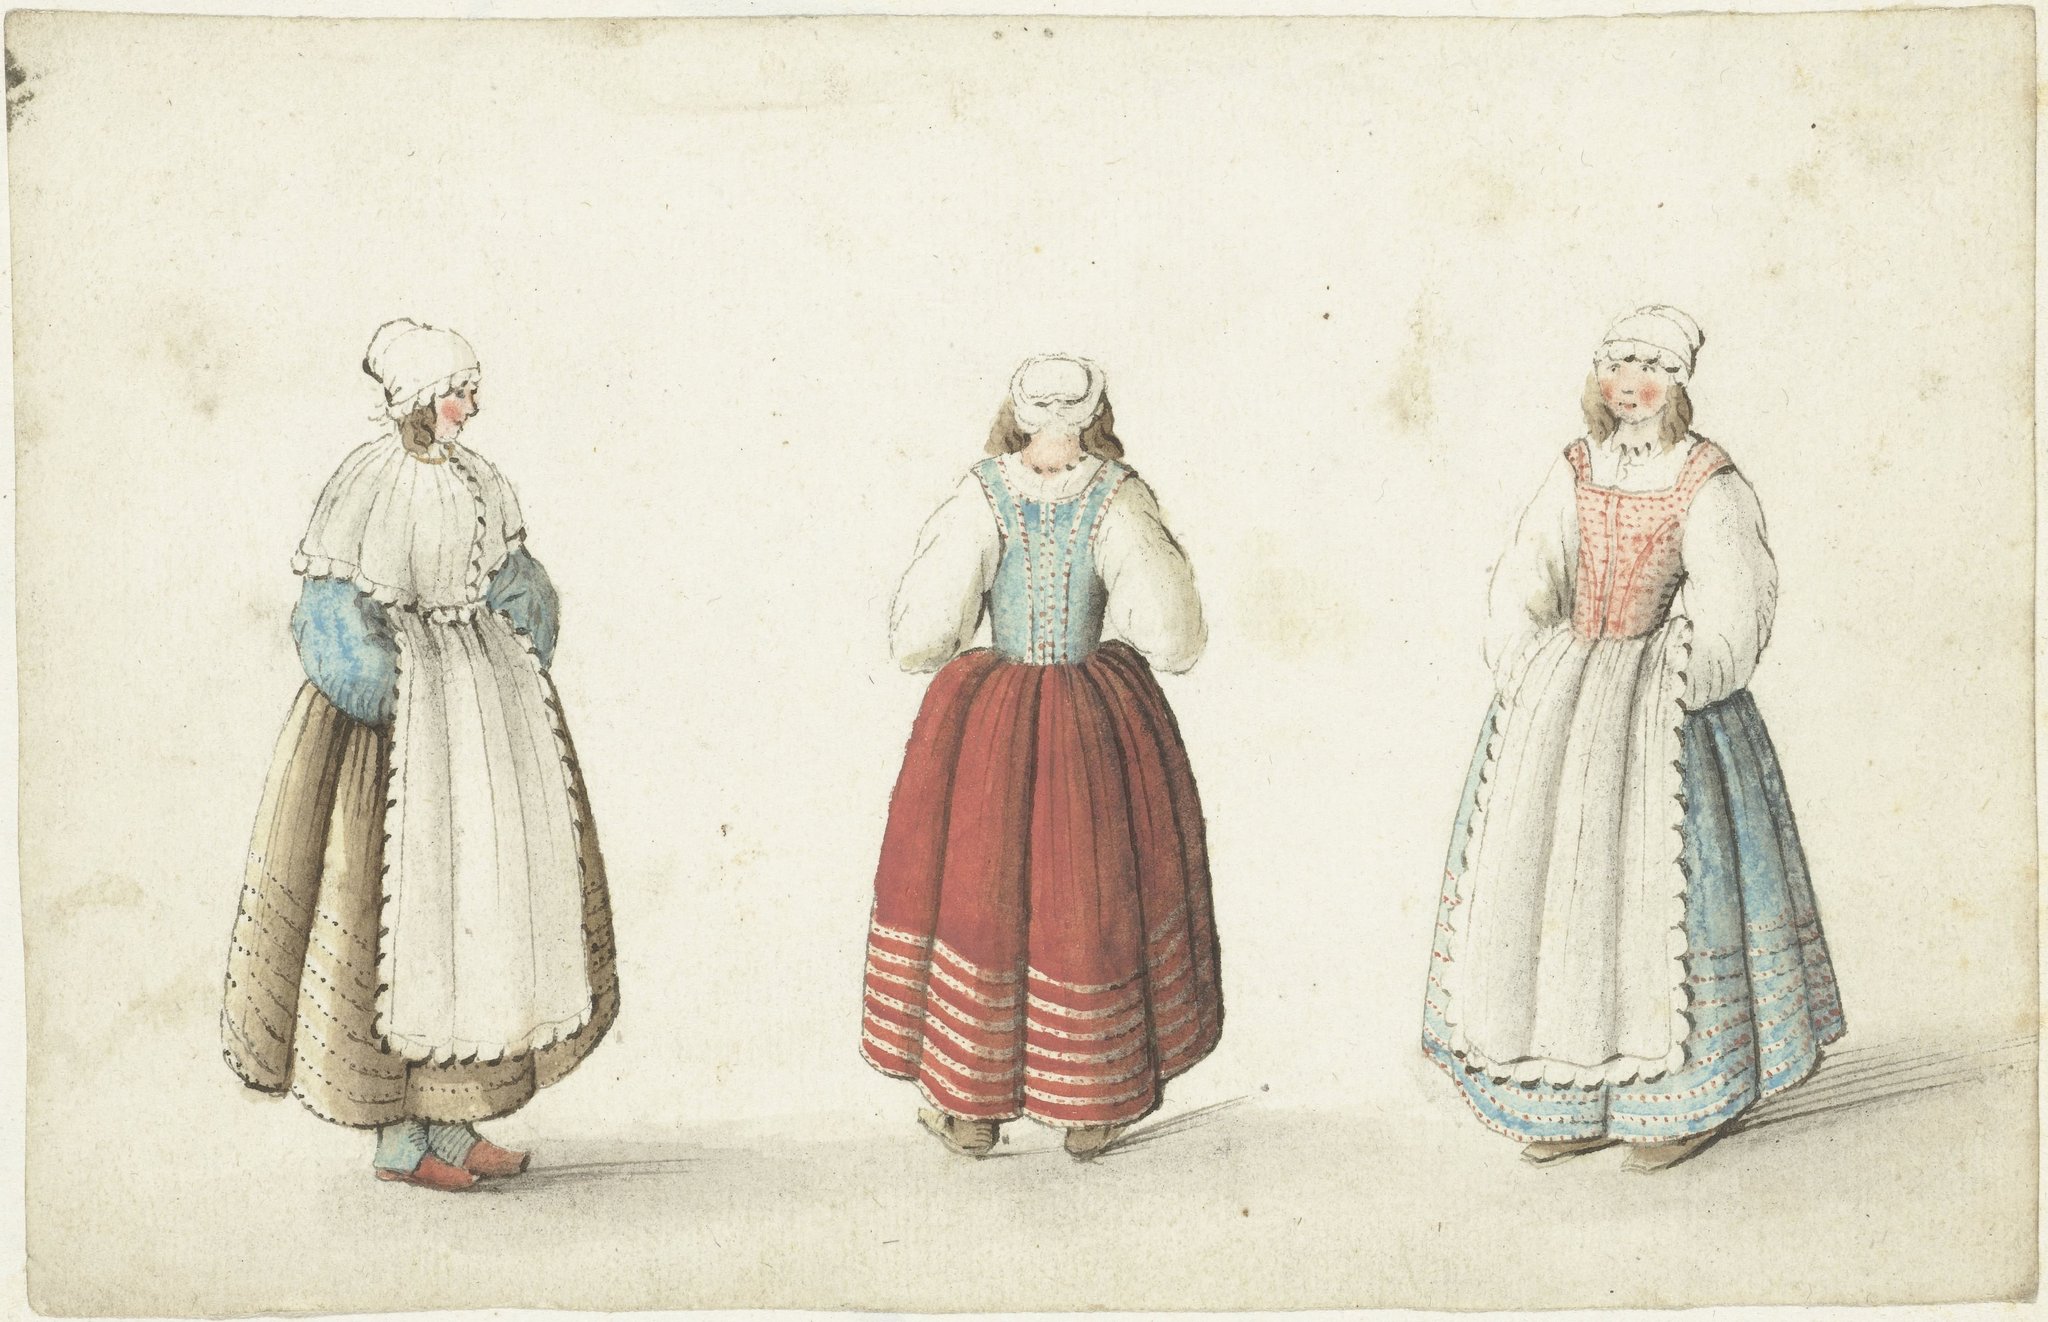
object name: drawing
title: Drie staande vrouwen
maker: gesina ter borch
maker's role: draughtsman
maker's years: 1633-1690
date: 1646-1654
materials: ink, paper, watercolor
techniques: brush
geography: zwolle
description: Tekening naast een andere tekening geplakt in het Familie-plakboek.